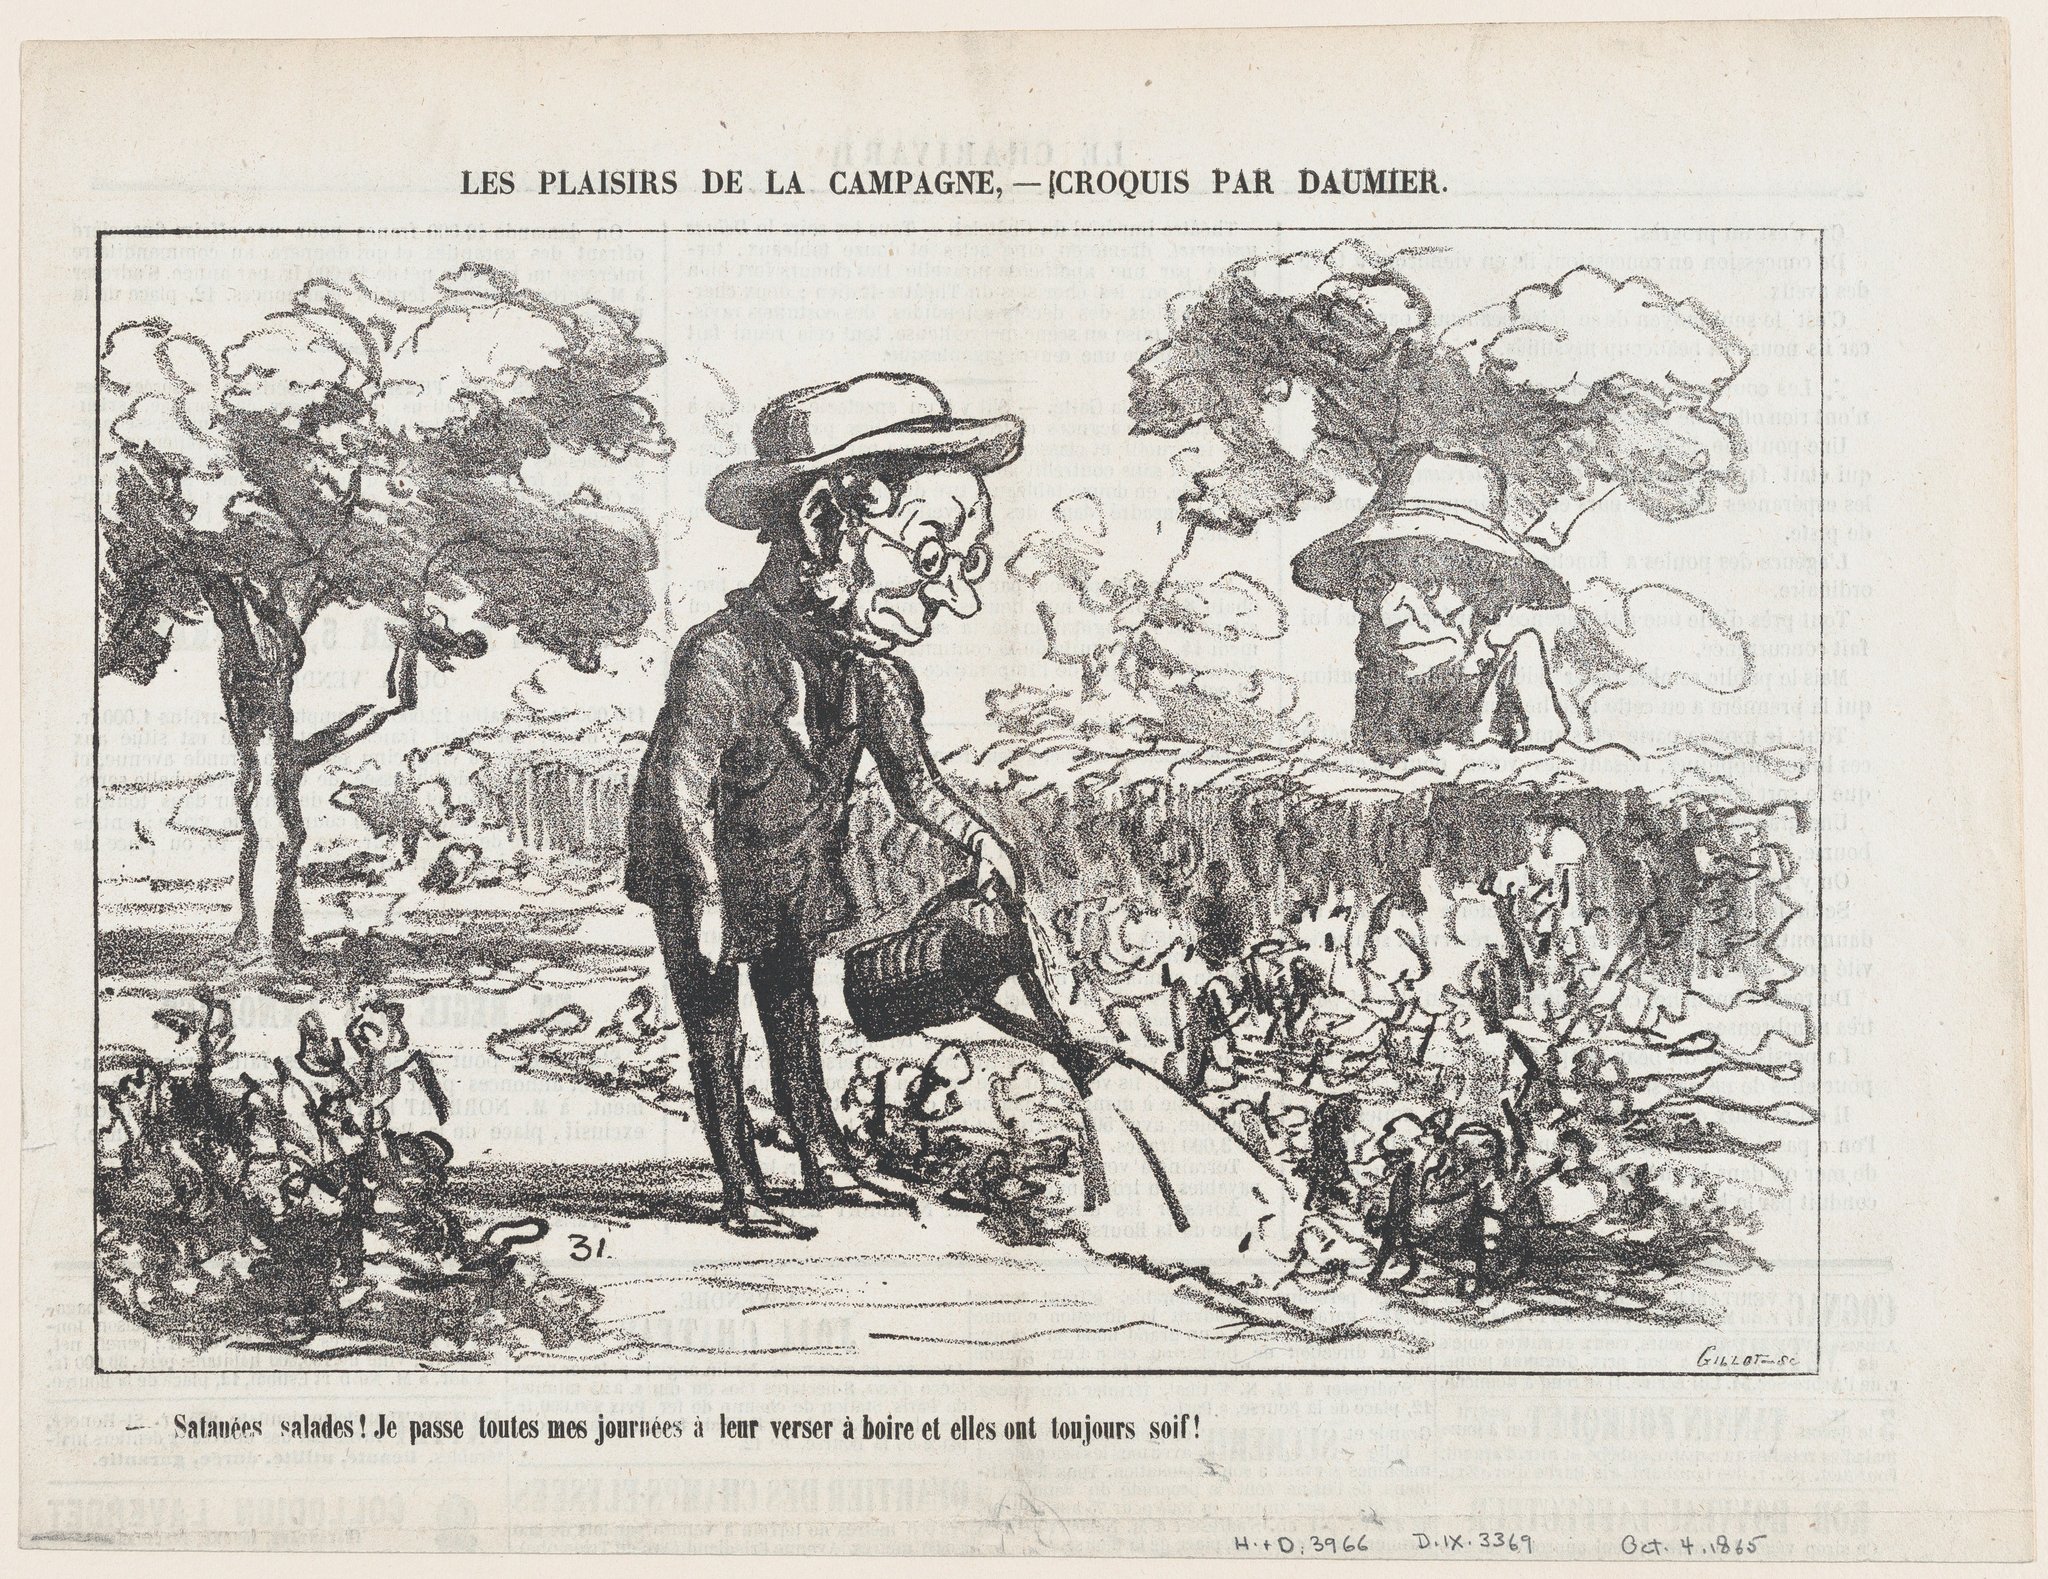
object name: print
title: Wretched lettuce... I am spending entire days watering it and it is still thirsty, from "The joys of country life"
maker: honoré daumier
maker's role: artist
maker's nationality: french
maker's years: 1808-1879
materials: paper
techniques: lithograph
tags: men,plants,working,gardeners